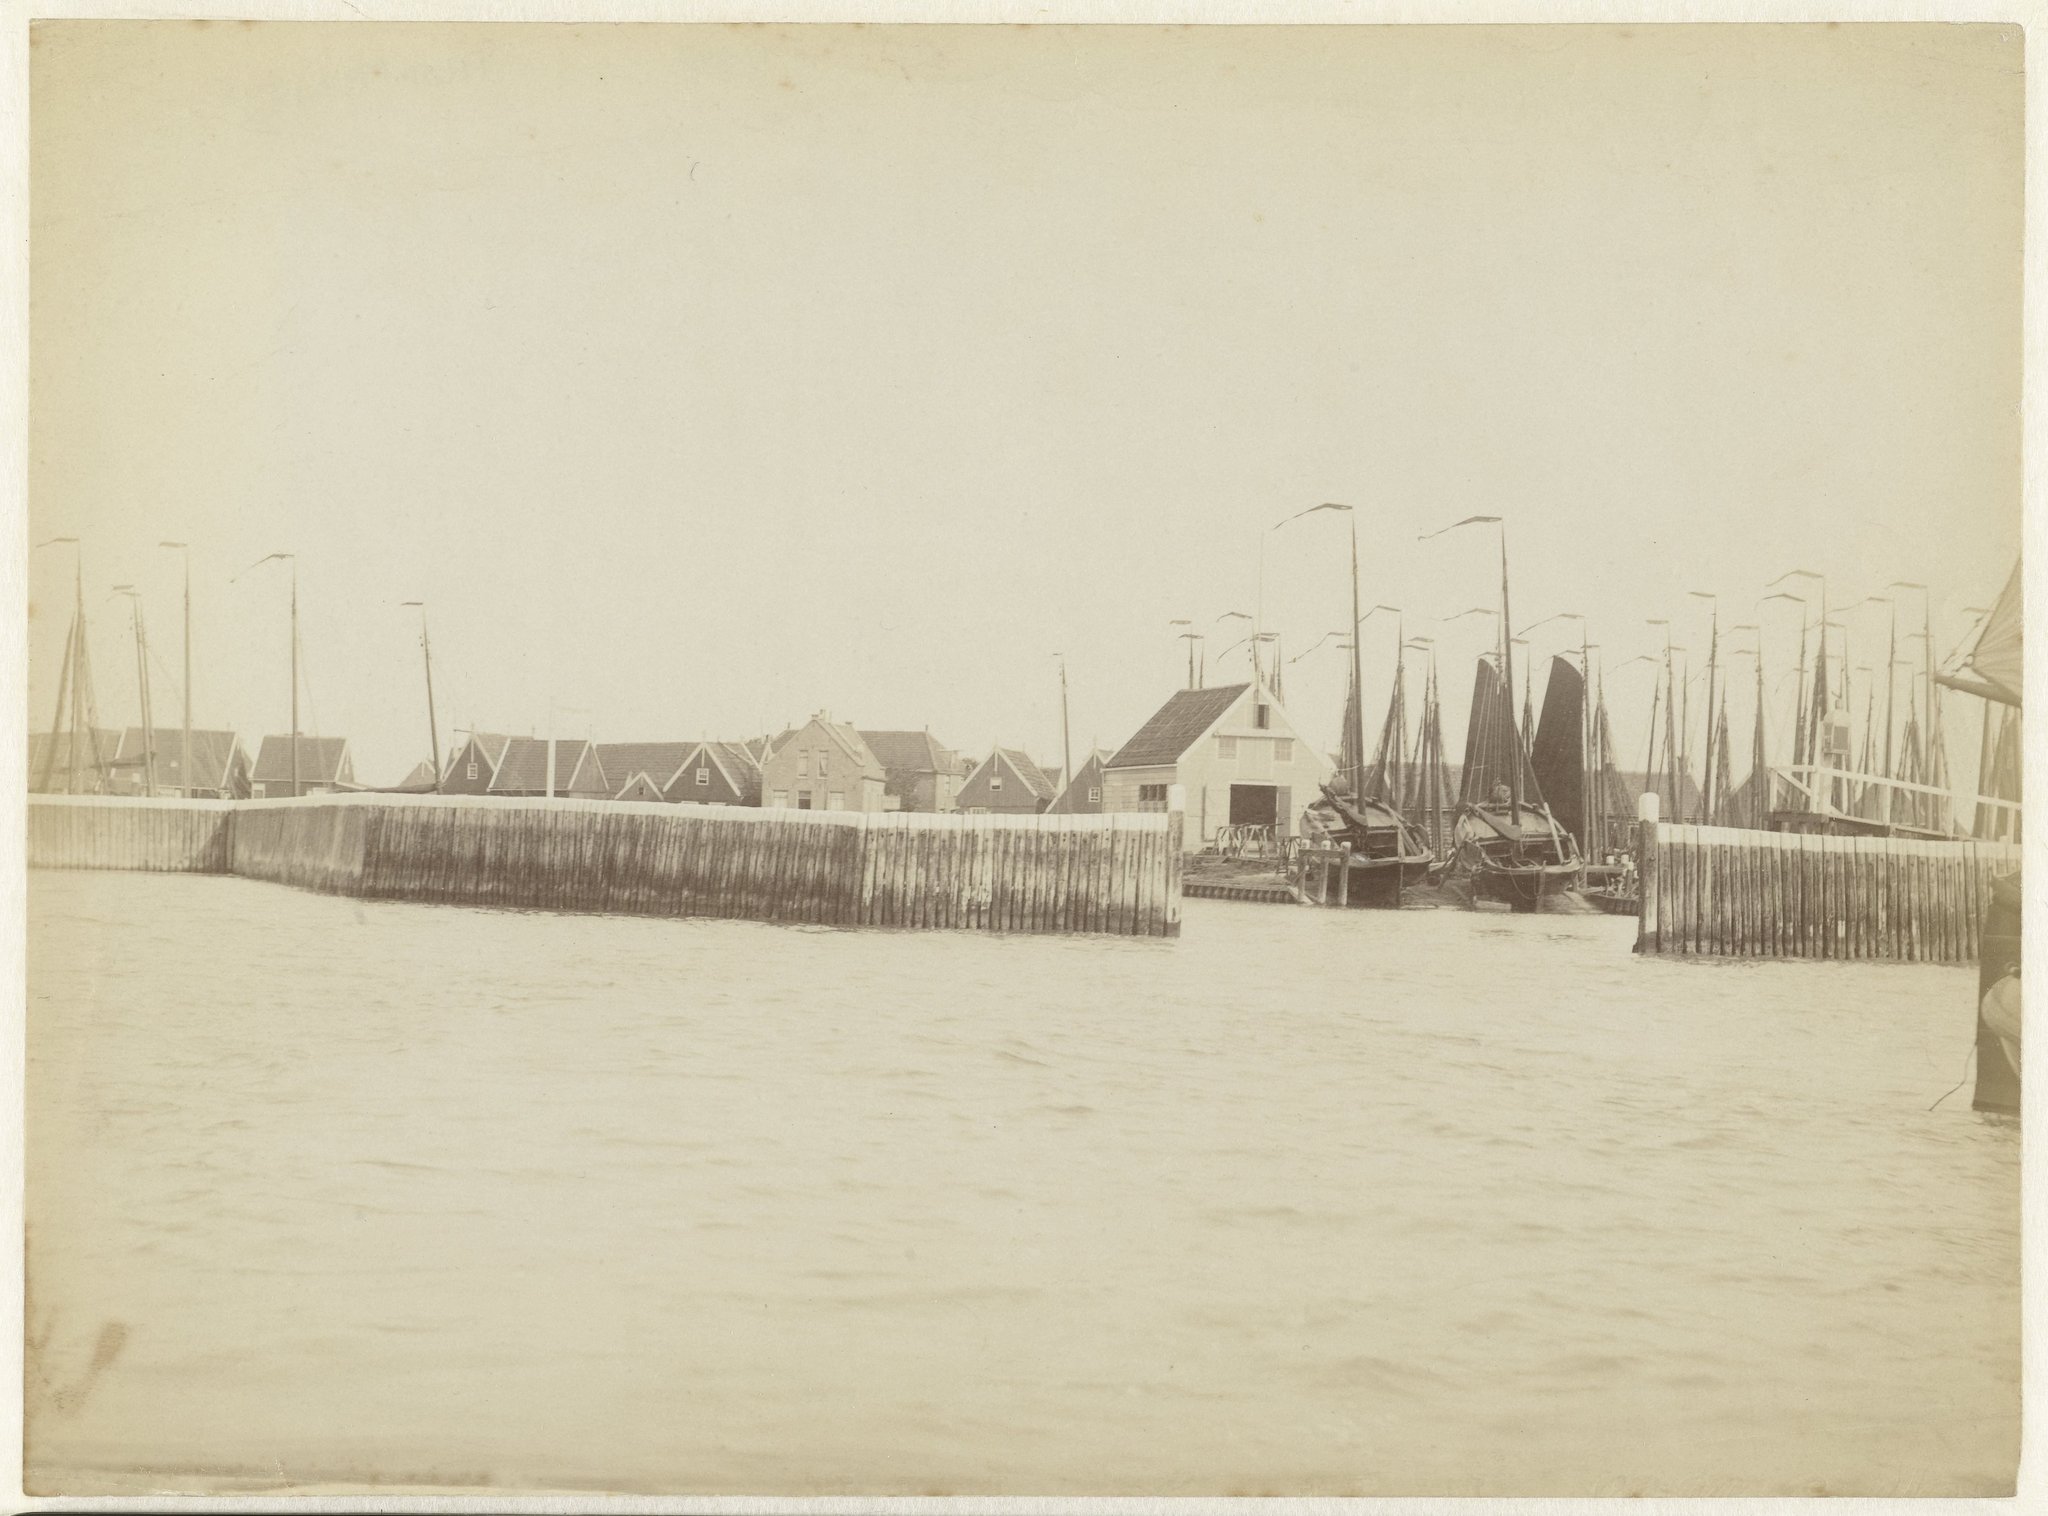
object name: photograph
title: Marken 1895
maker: Anonymous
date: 1895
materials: paper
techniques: albumen print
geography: marken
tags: harbour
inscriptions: inscription: ‘Marken 1895’